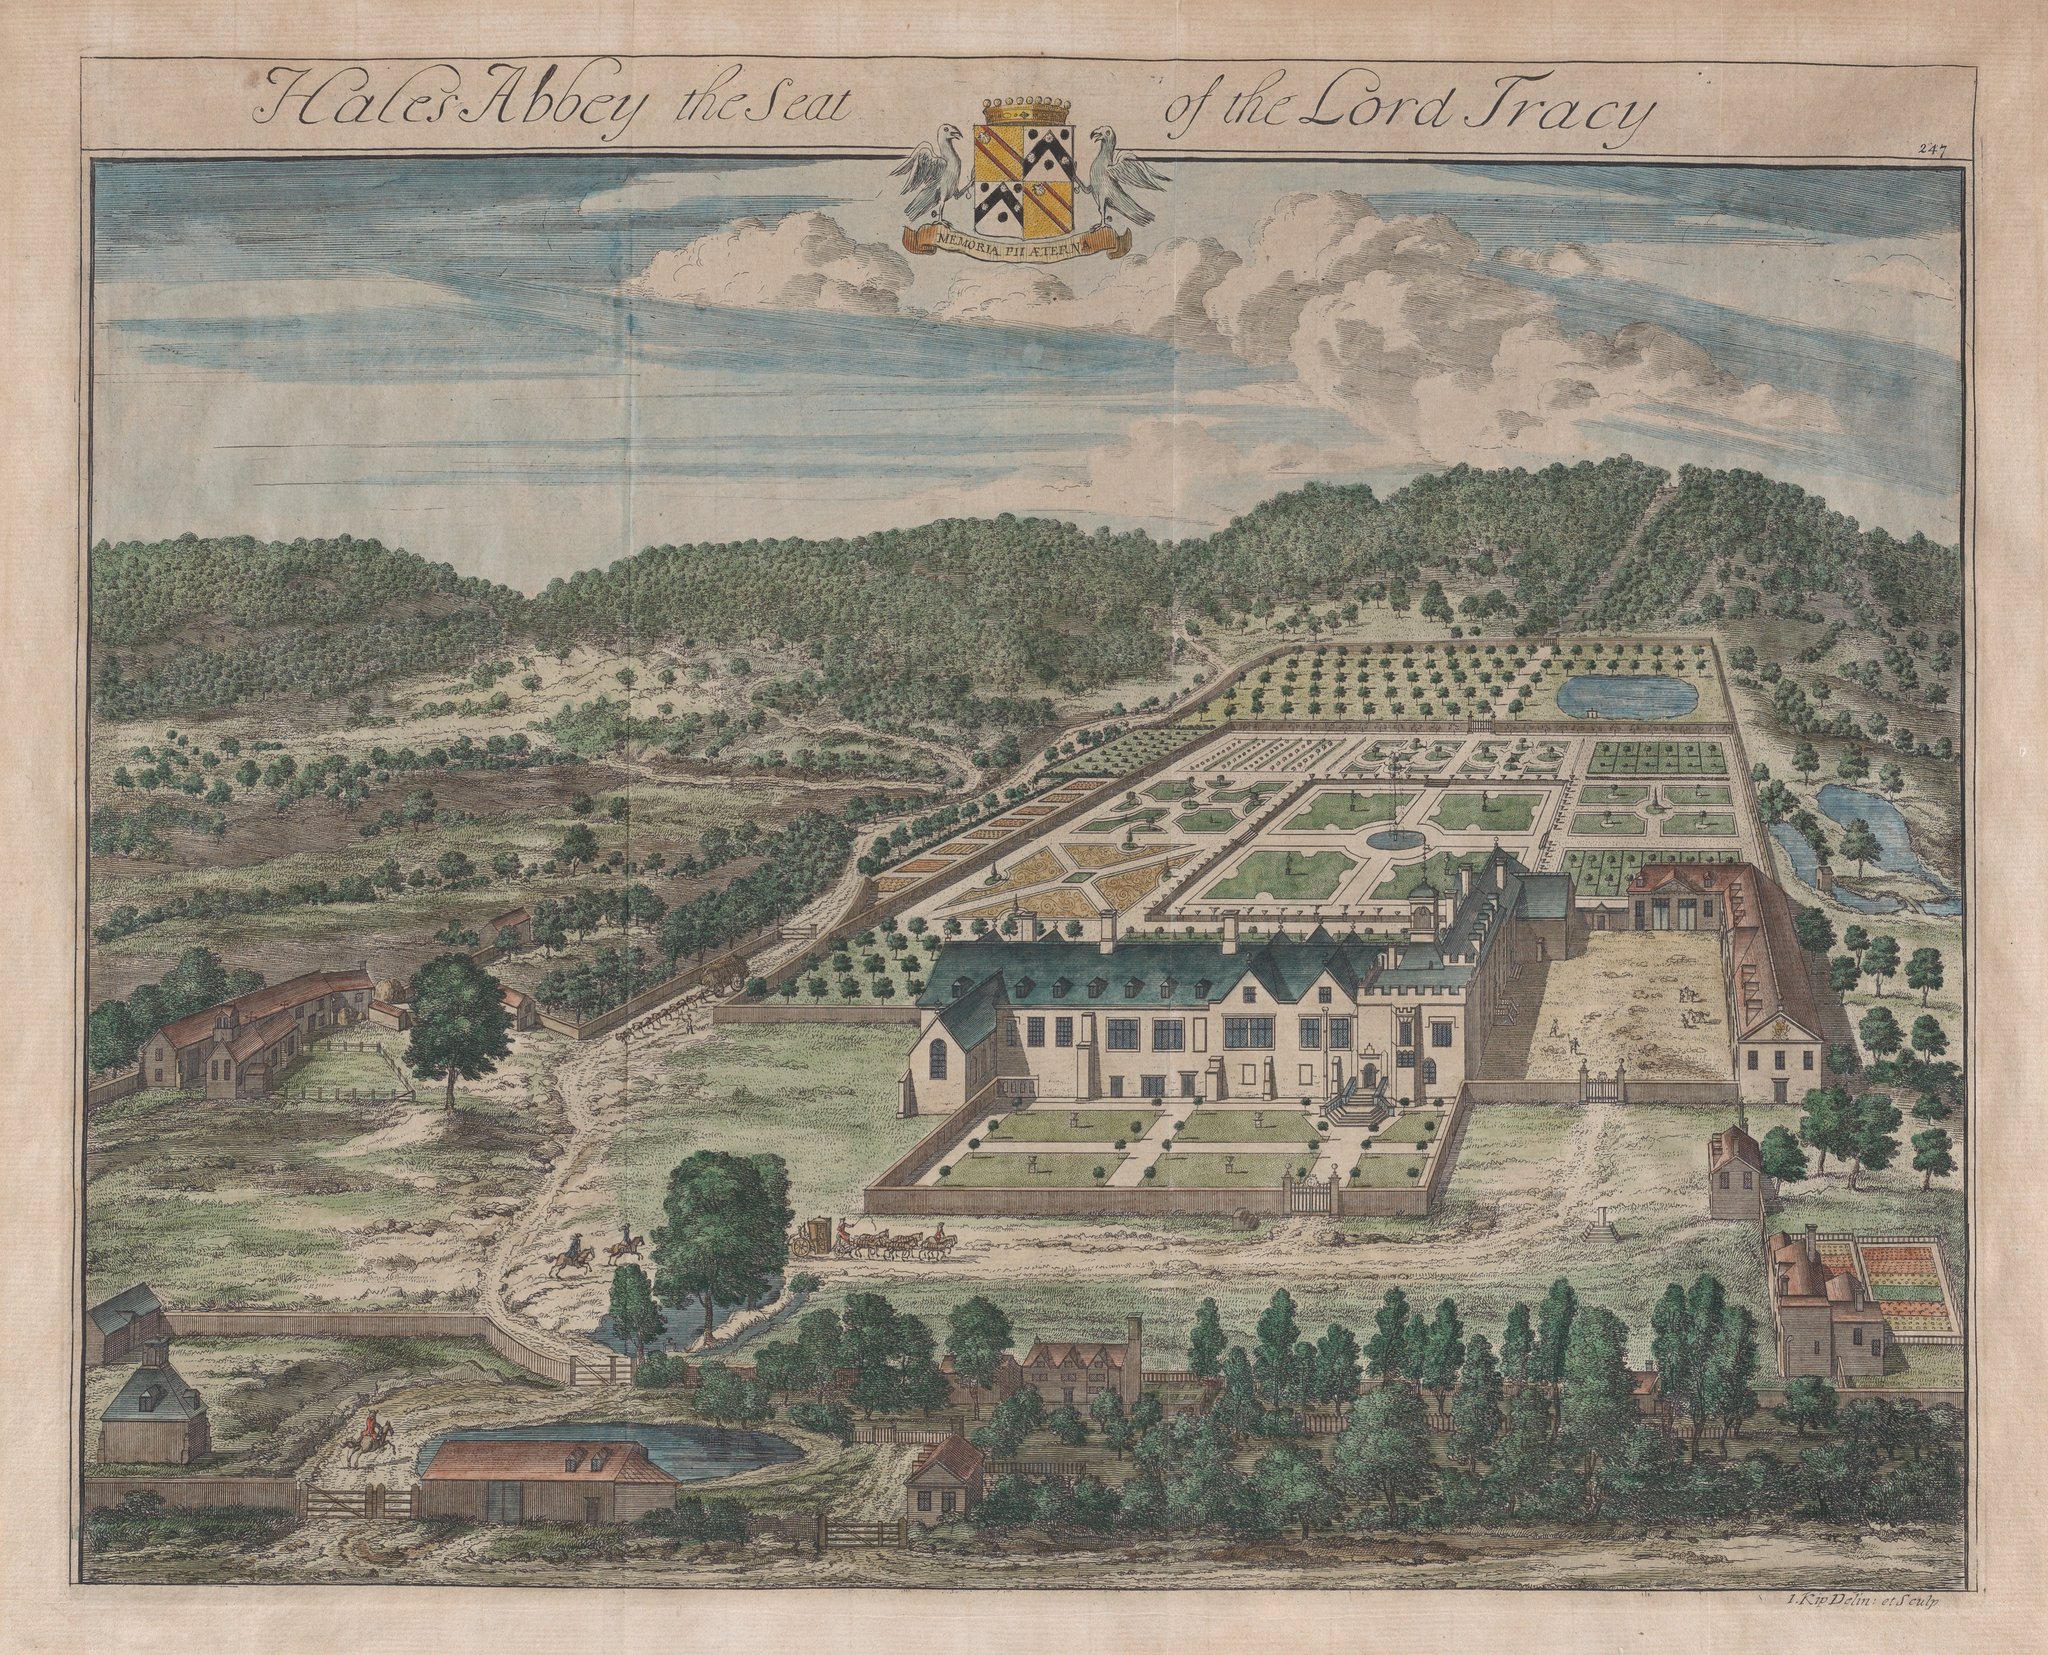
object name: print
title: Hales Abbey, The Seat of Lord Tracy, plate 247 from "The Ancient and Present State of Gloucestershire"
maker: johannes kip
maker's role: artist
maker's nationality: dutch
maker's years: 1653-1722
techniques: engraving, etching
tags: houses,gardens,landscapes,coat of arms